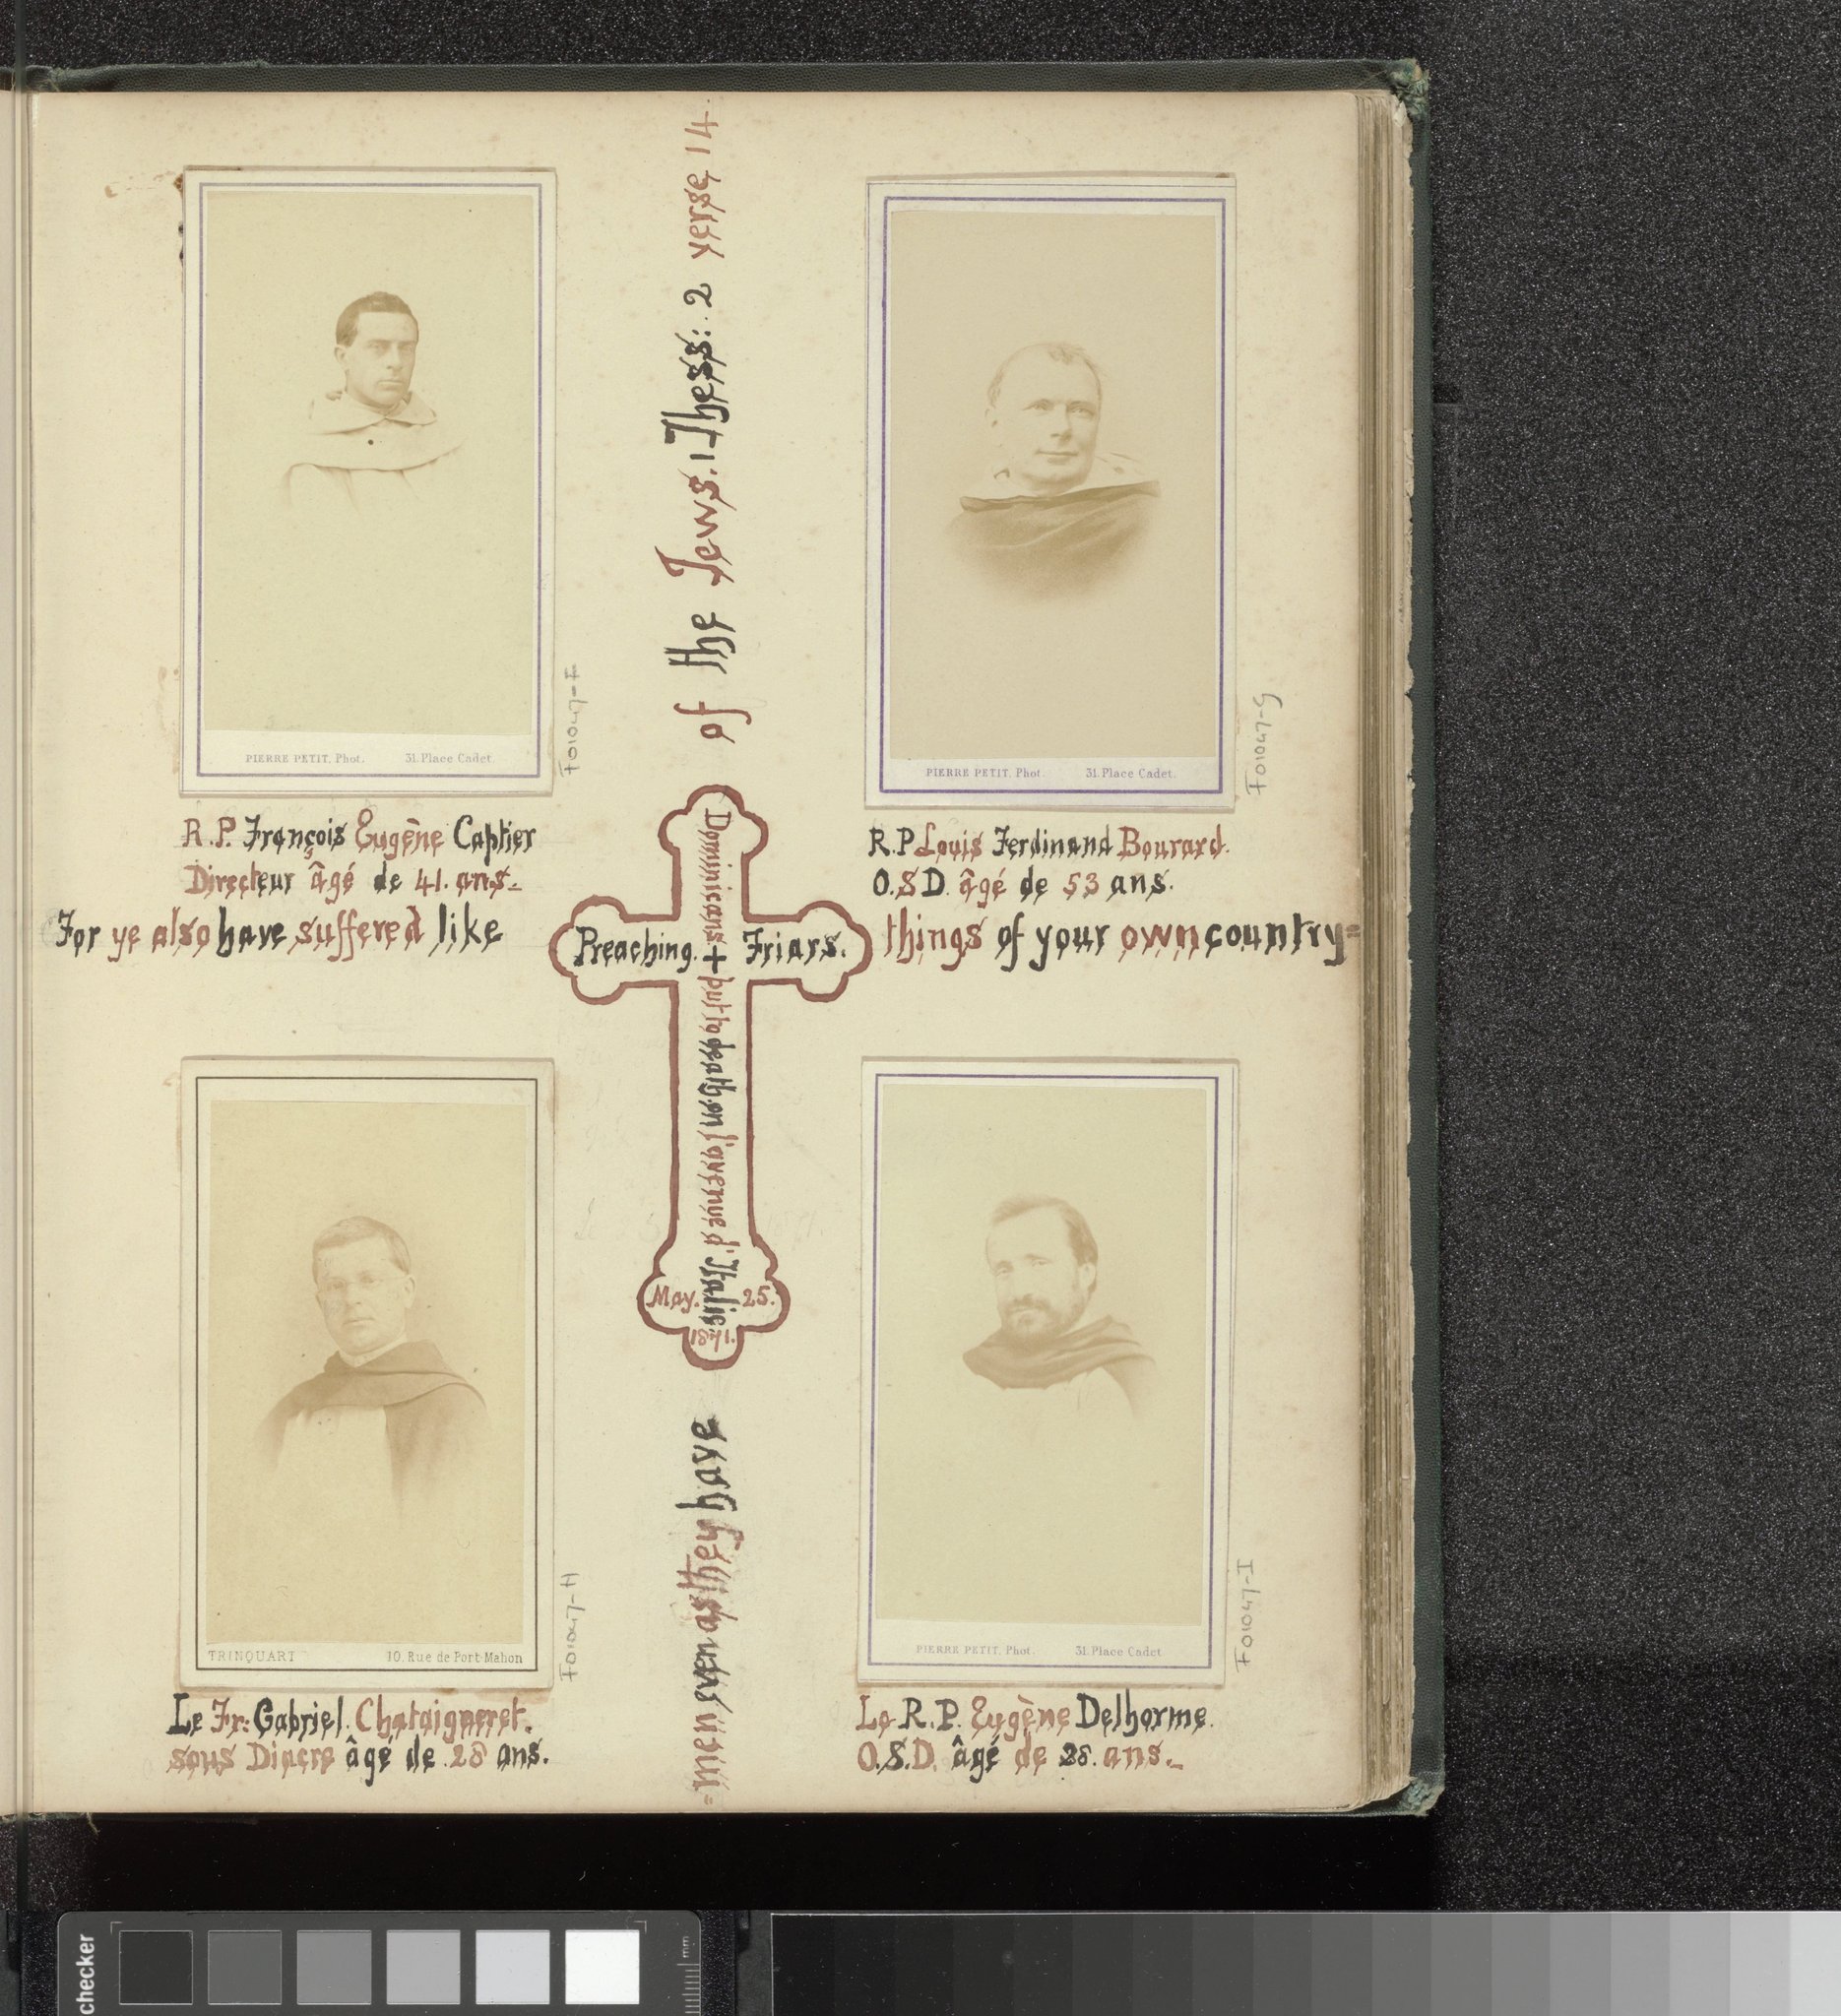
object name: album leaf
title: Portret van R.P. Louis Ferdinand Bourard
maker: pierre petit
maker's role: fotograaf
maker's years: 1832-1909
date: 1871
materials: cardboard, paper, photographic support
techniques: albumen print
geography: paris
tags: monk(s), friar(s)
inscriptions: address: ‘31, Place Cadet’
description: Onderdeel van Herdenkingsalbum van rooms-katholieke geestelijken gevallen tijdens de Commune van Parijs.